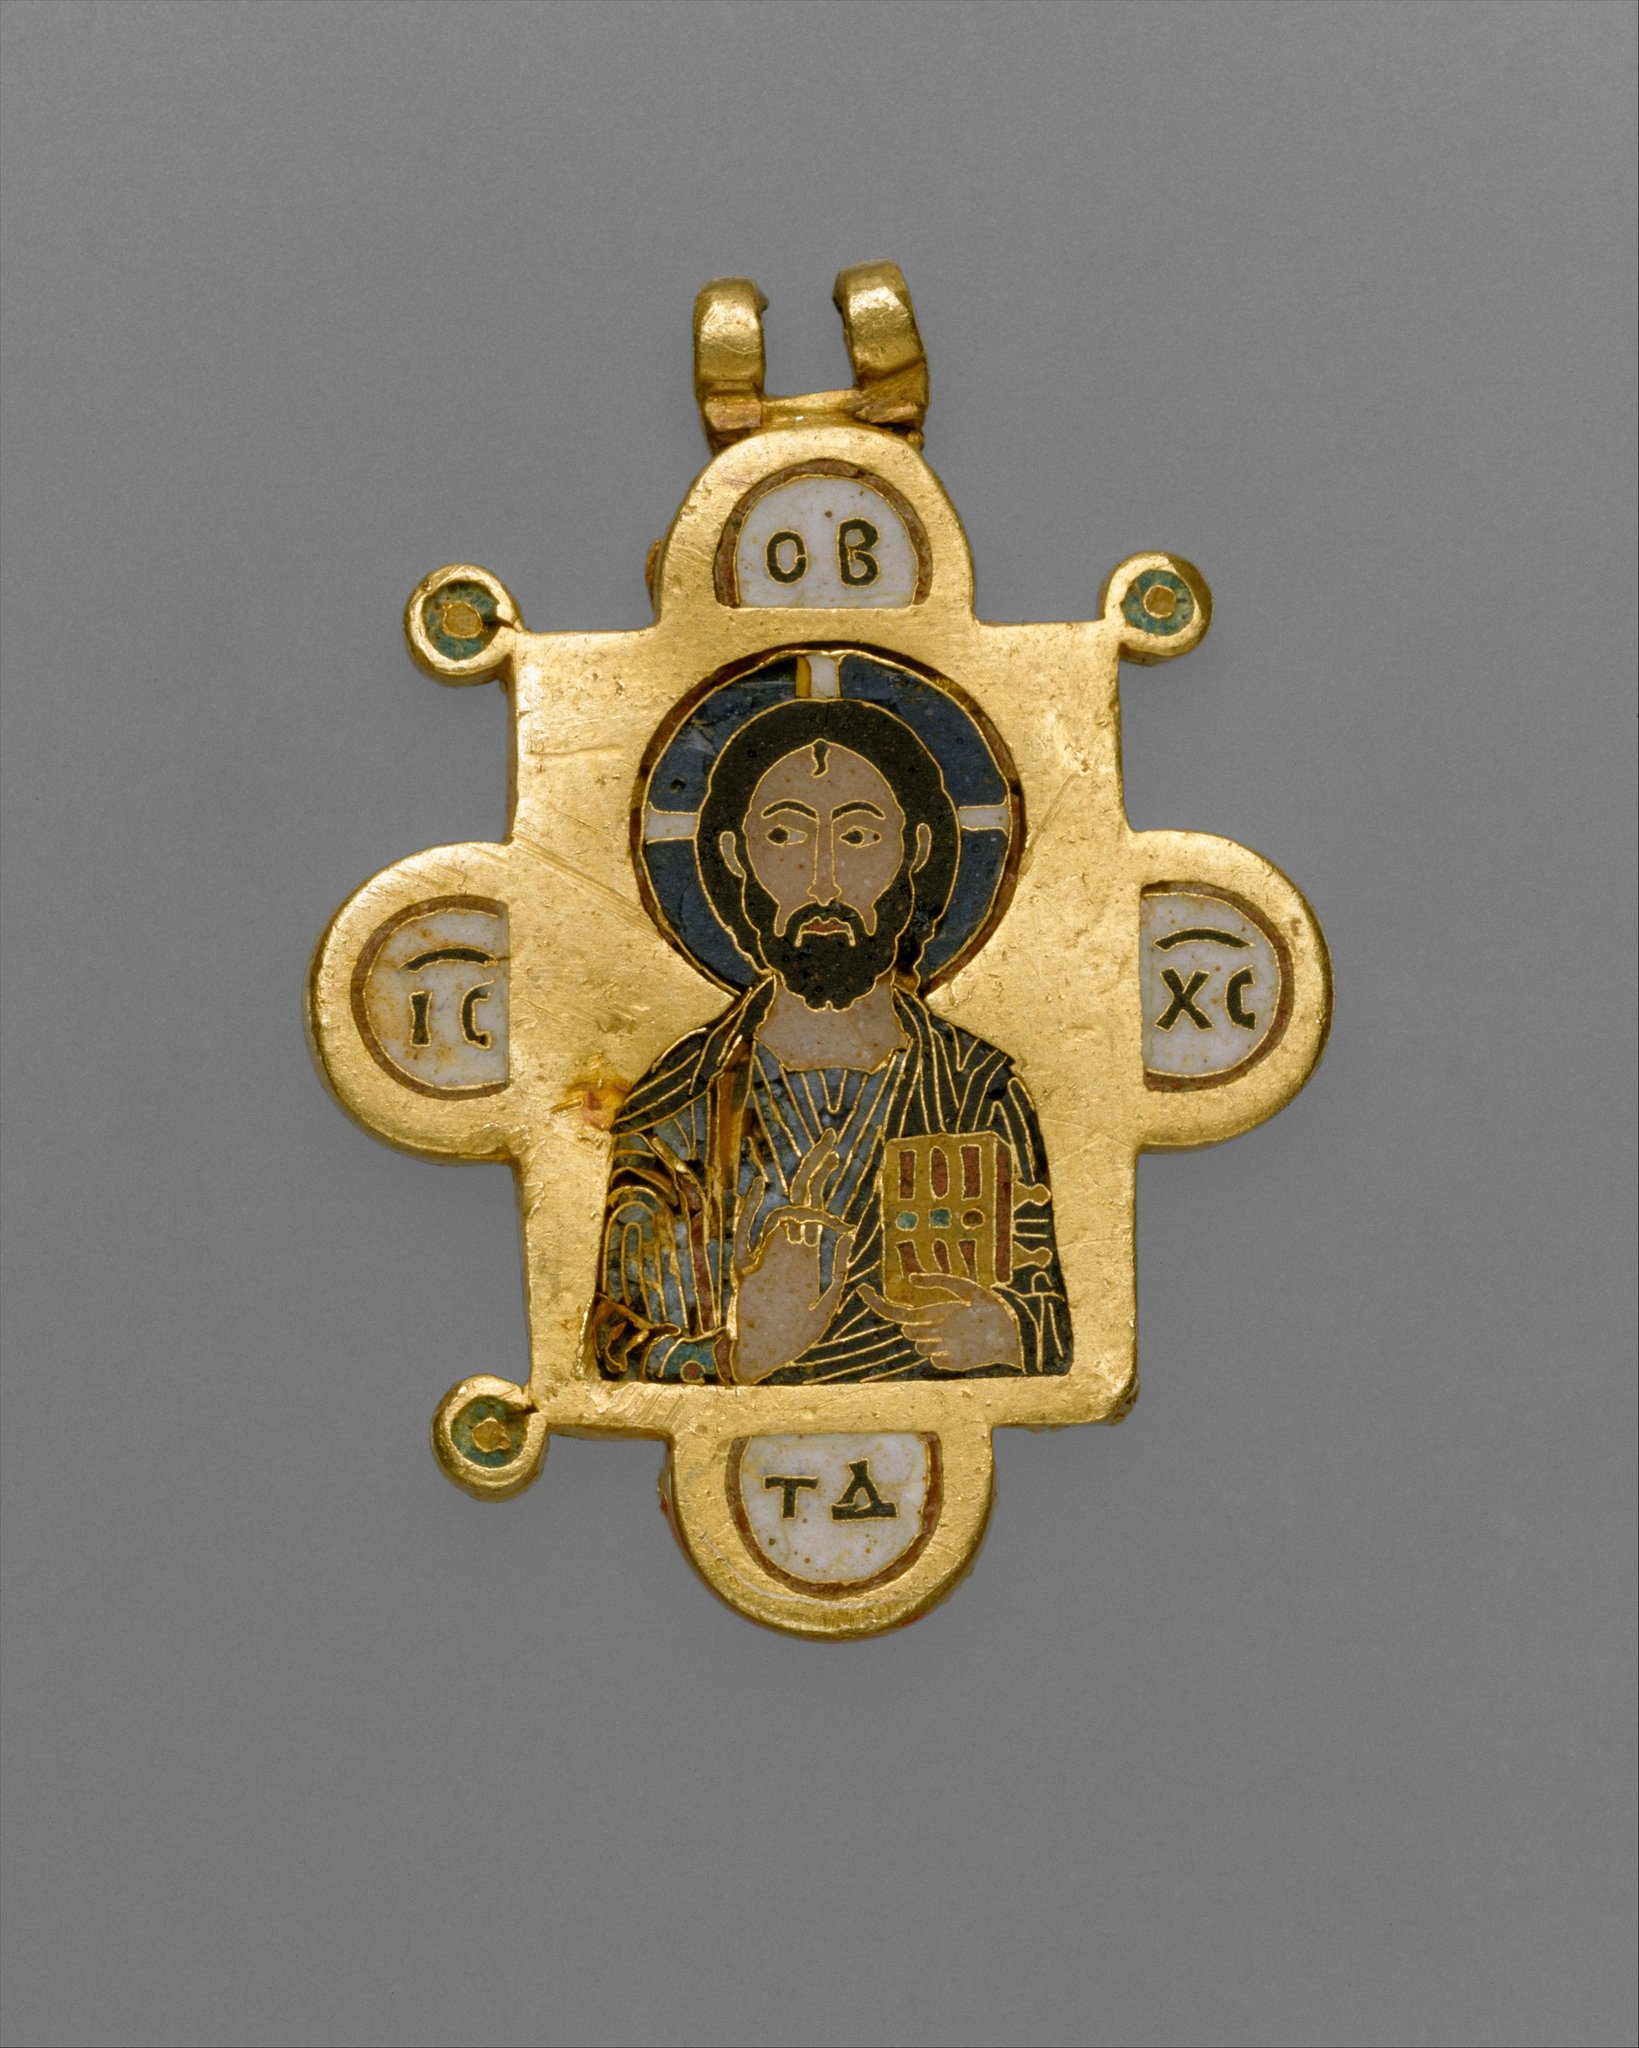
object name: pendant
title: Double-Sided Pendant Icon with the Virgin and Christ Pantokrator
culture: byzantine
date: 1100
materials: enamel, gold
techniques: enamel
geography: constantinople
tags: christ,virgin mary